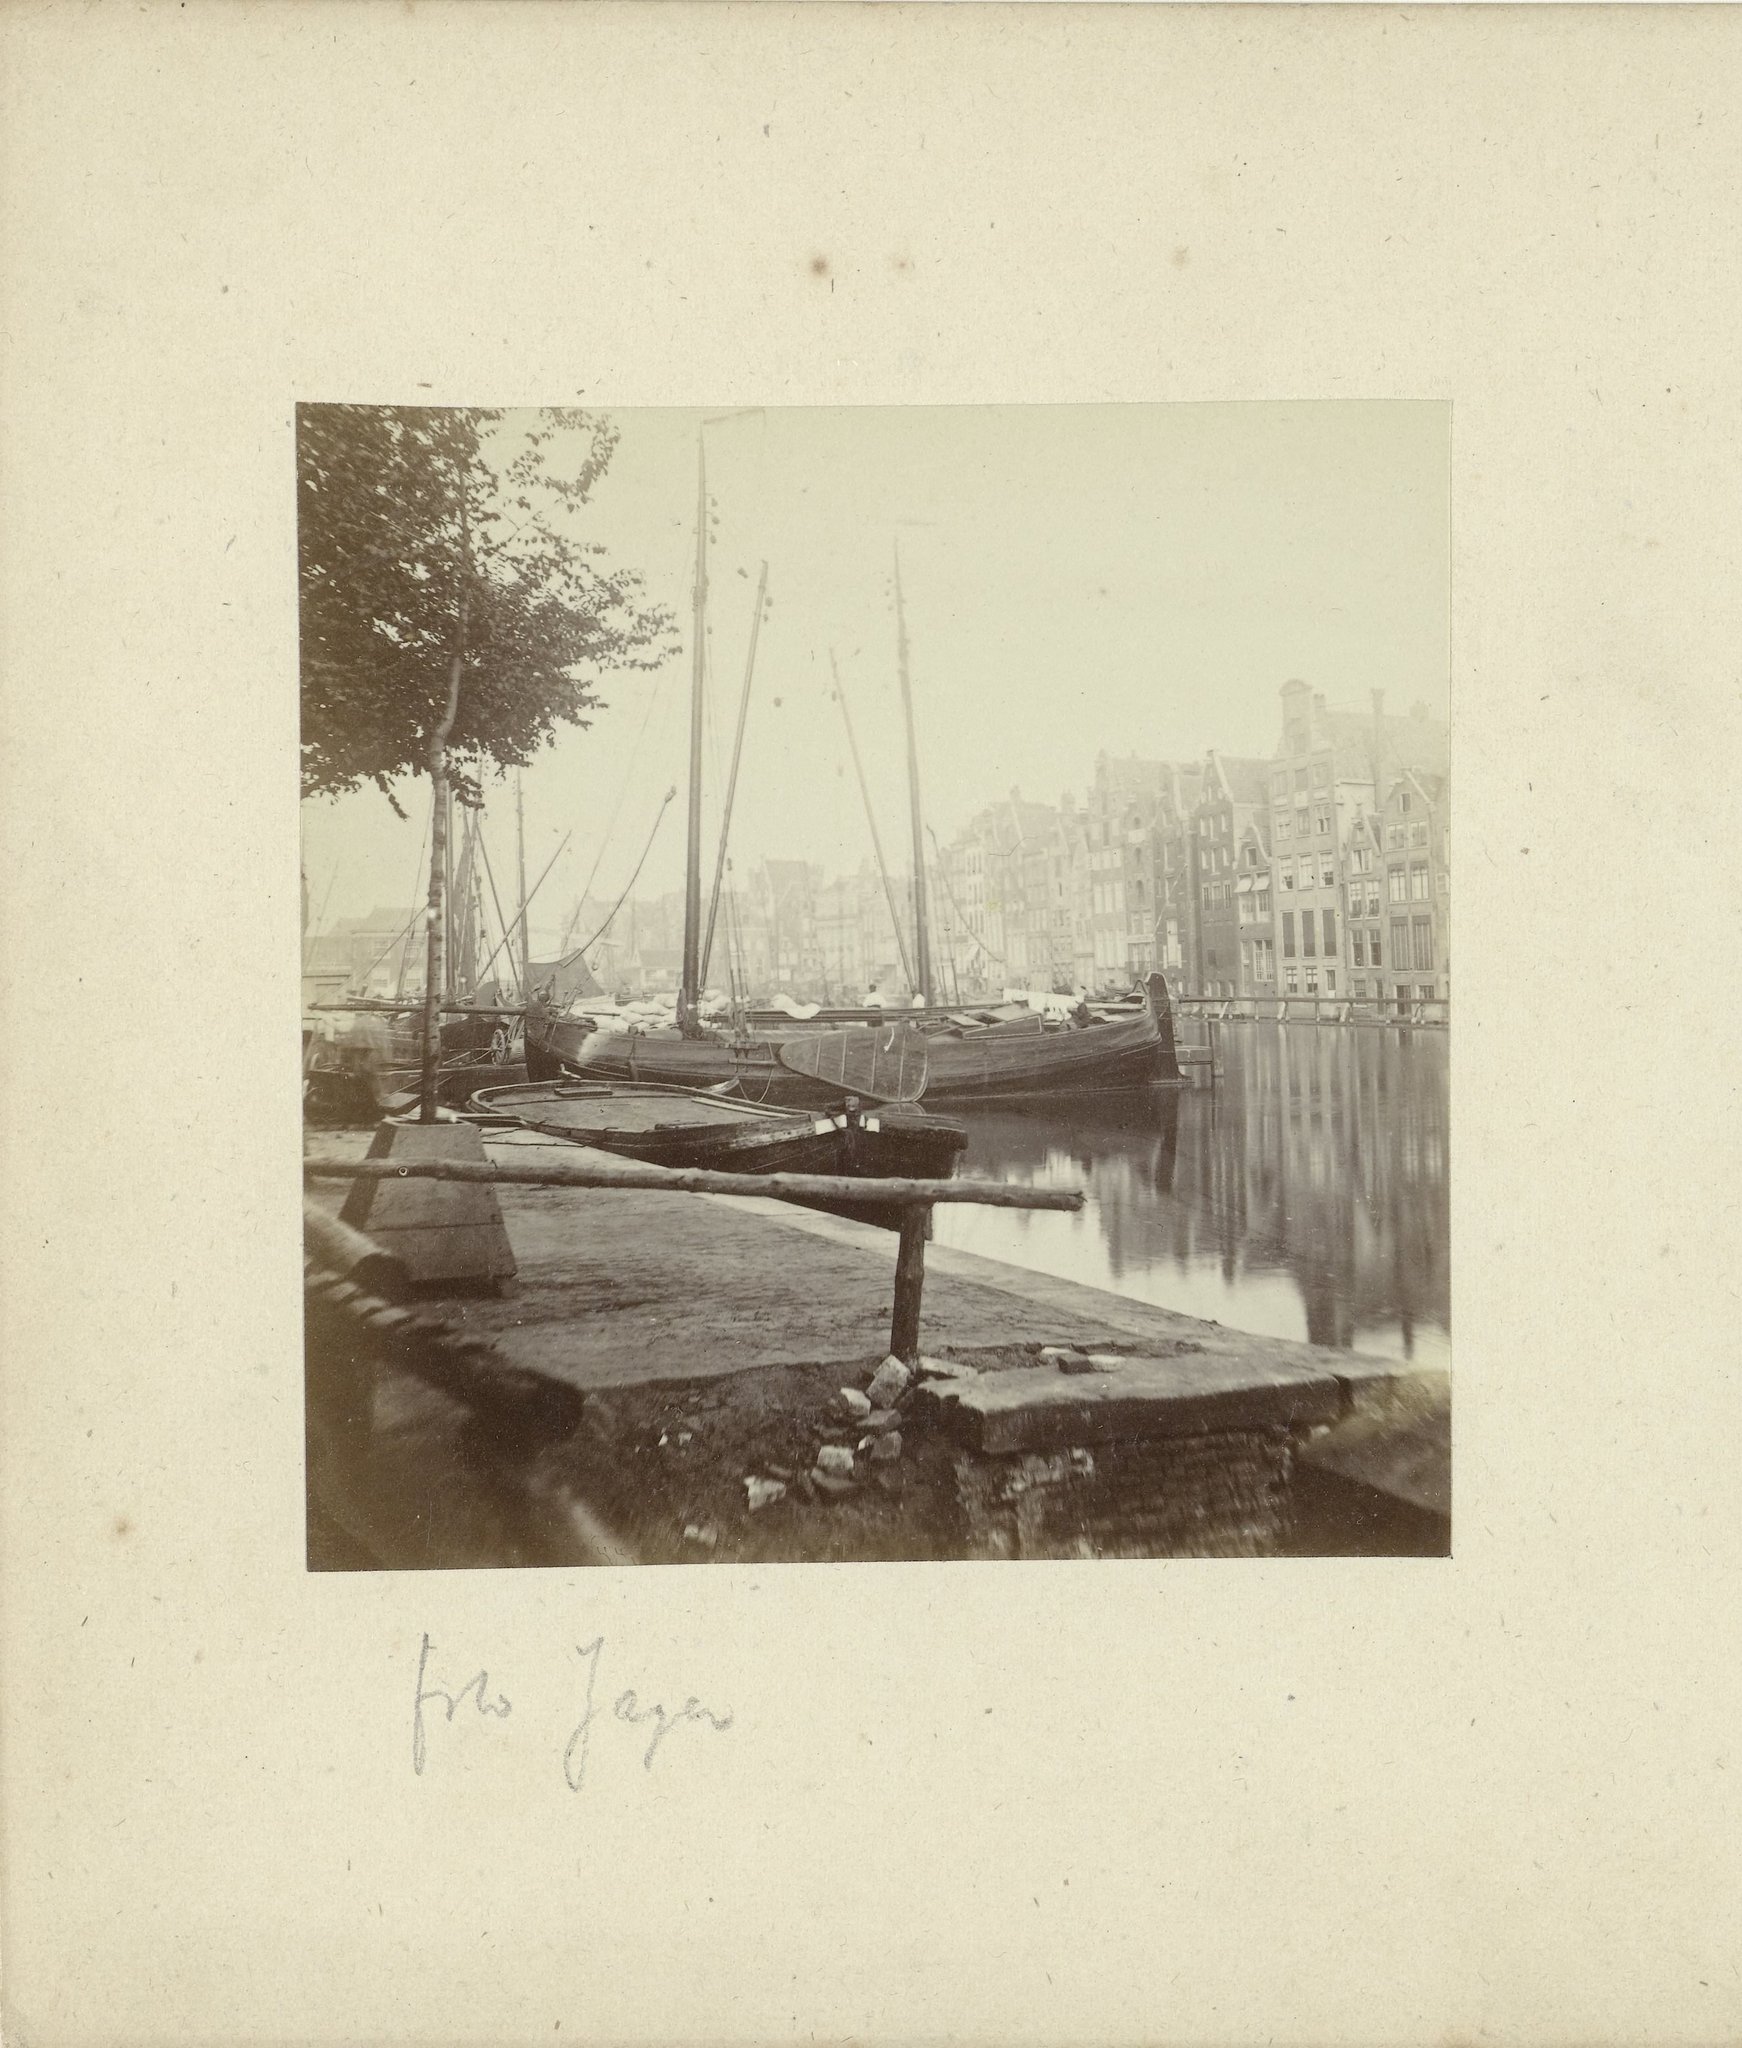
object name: photograph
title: Gezicht op het Damrak met zeilschepen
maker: andries jager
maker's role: publisher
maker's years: 1825-1905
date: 1860-1875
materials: cardboard, paper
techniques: albumen print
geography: amsterdam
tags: ships (in general) - cc - more than one ship